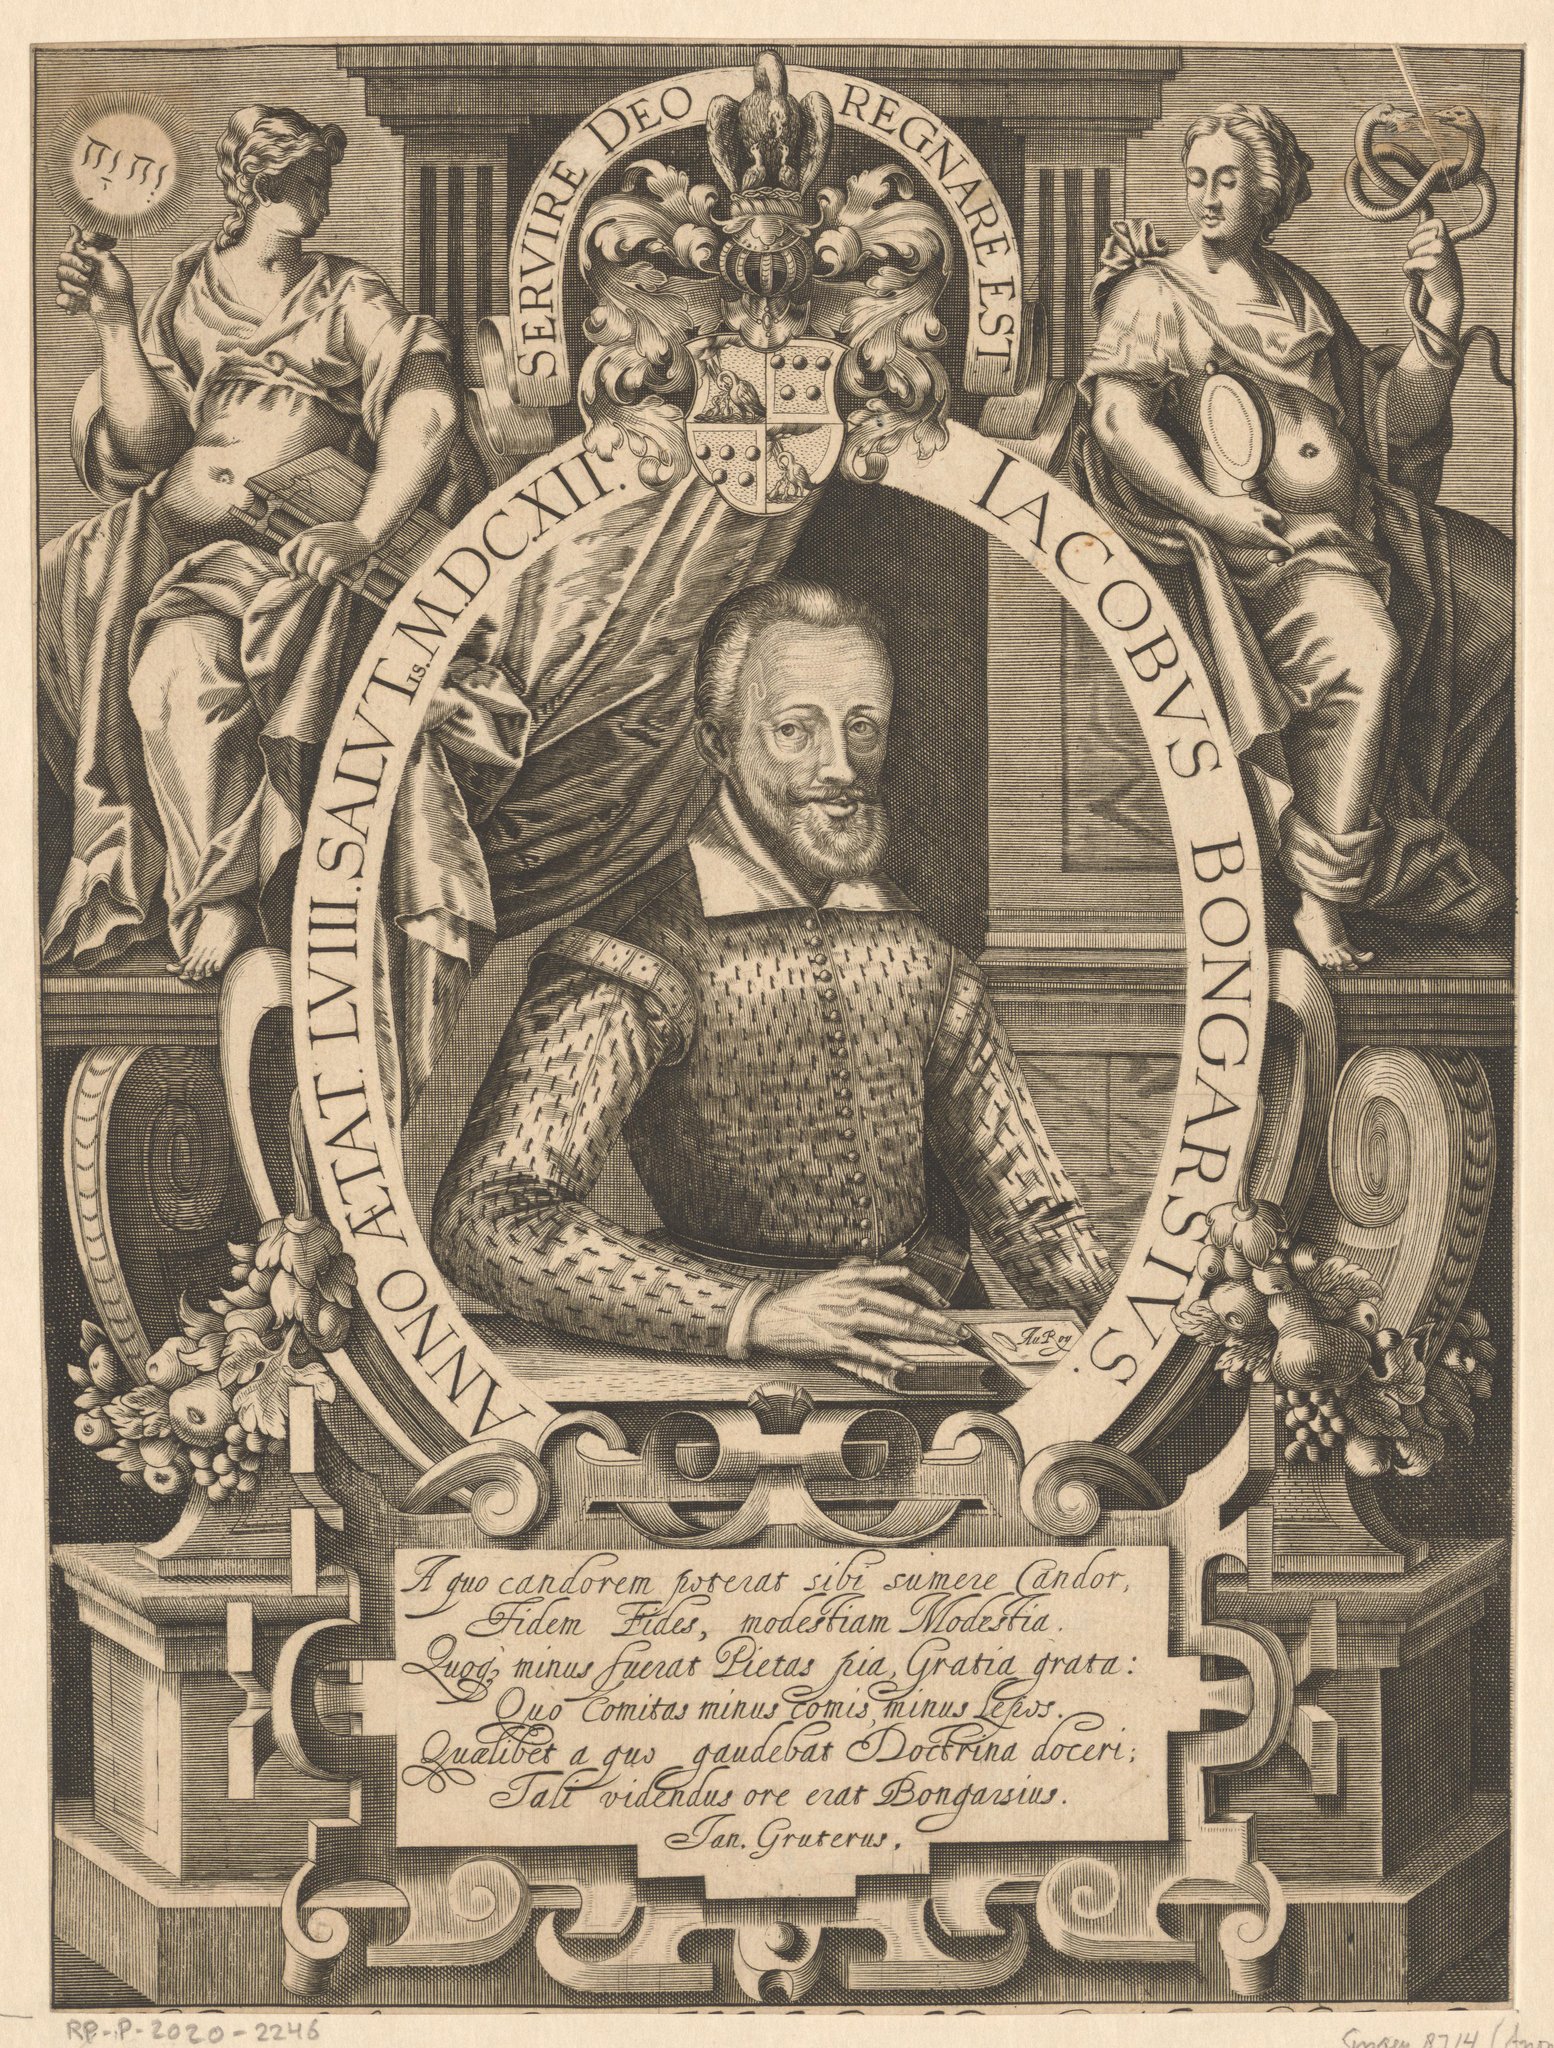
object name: print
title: Portret van Jacques Bongars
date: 1612-1657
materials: paper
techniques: engraving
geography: straatsburg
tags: paris, hebrew script, historical persons, book, armorial bearing, heraldry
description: Met midden boven het portret zijn wapenschild.